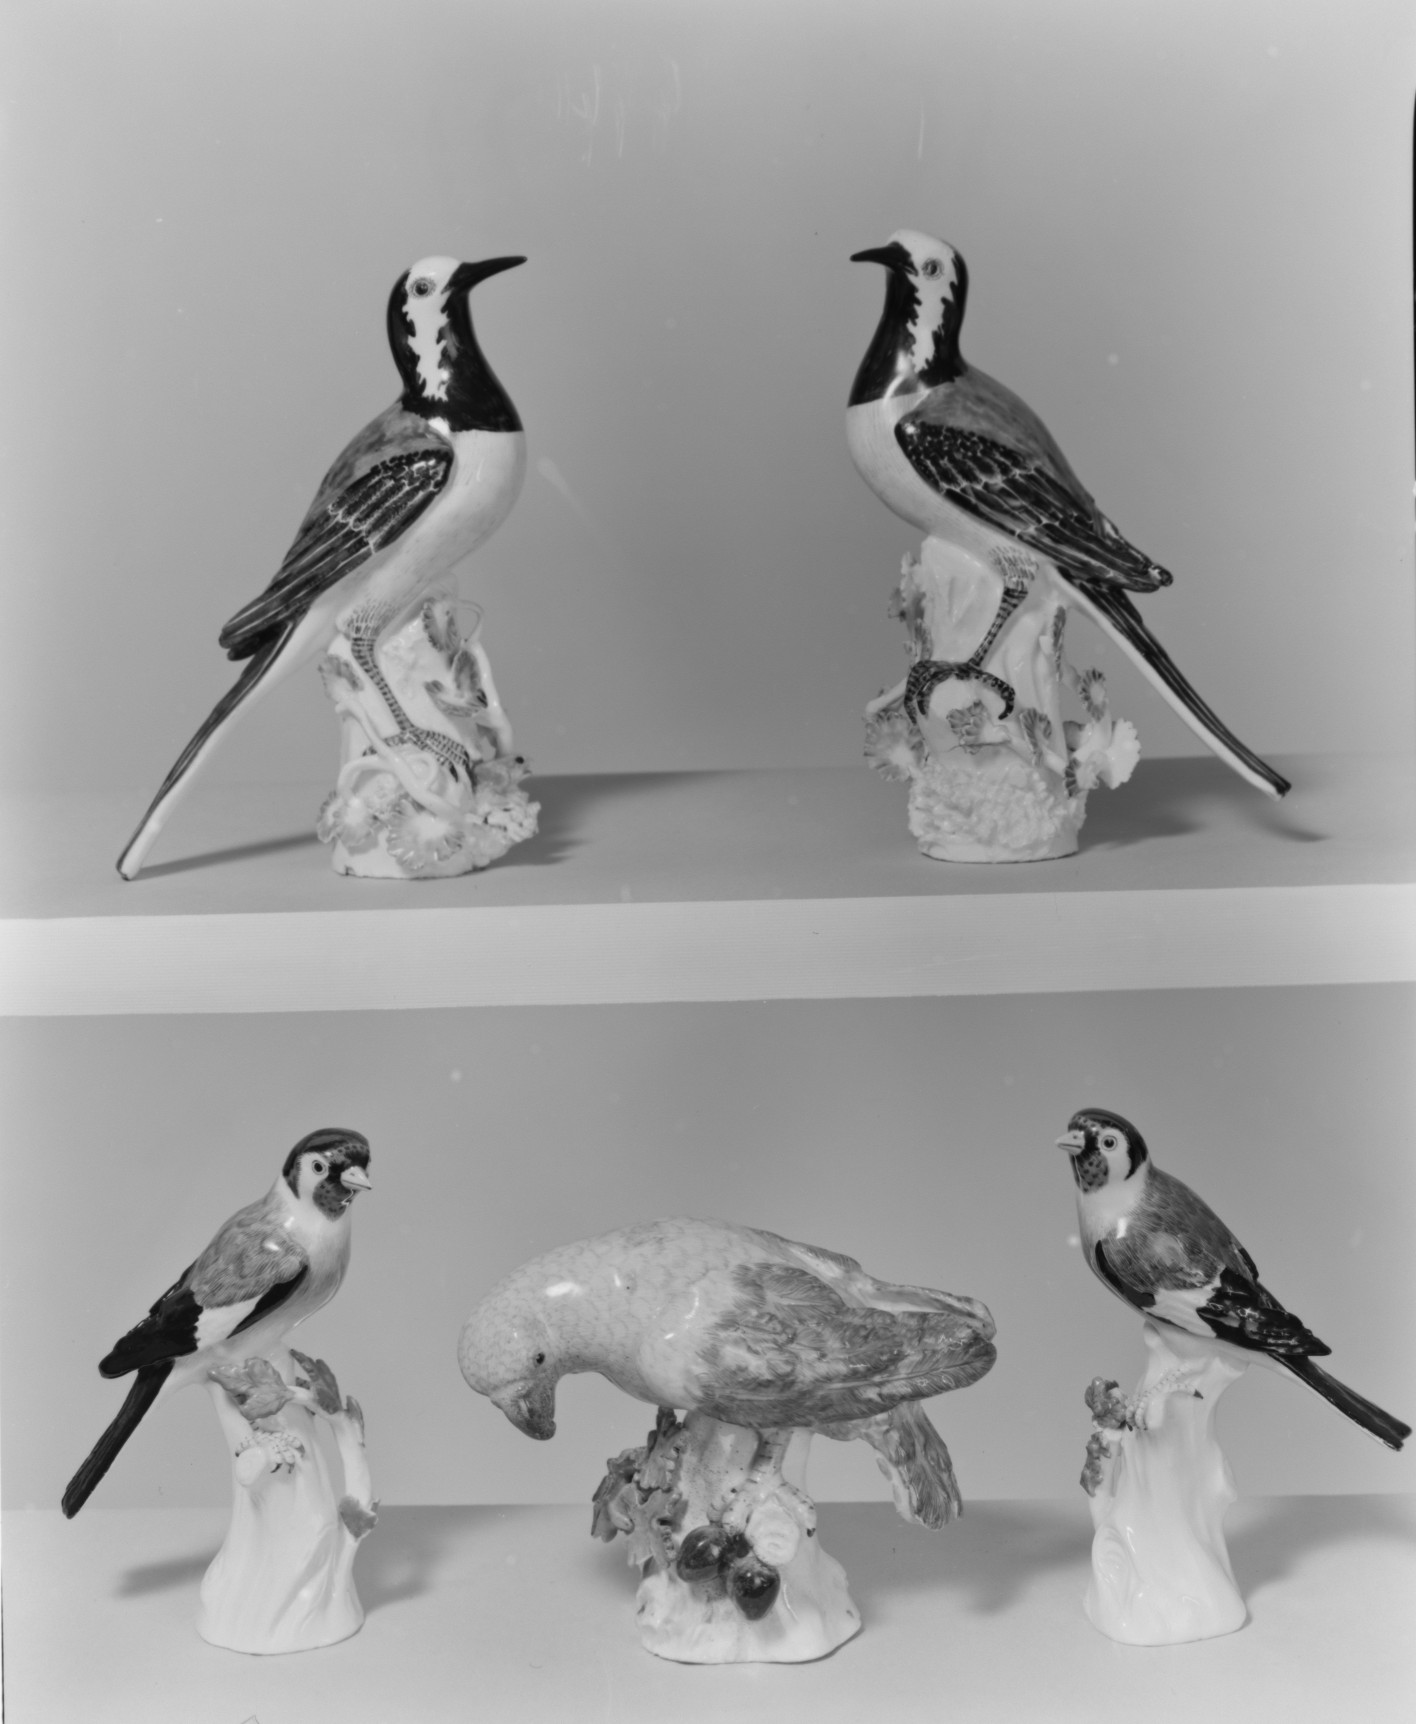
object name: figure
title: Wagtail (one of a pair)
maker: meissen manufactory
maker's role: manufactory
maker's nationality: german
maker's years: 1710-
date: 1733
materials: hard paste porcelain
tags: birds